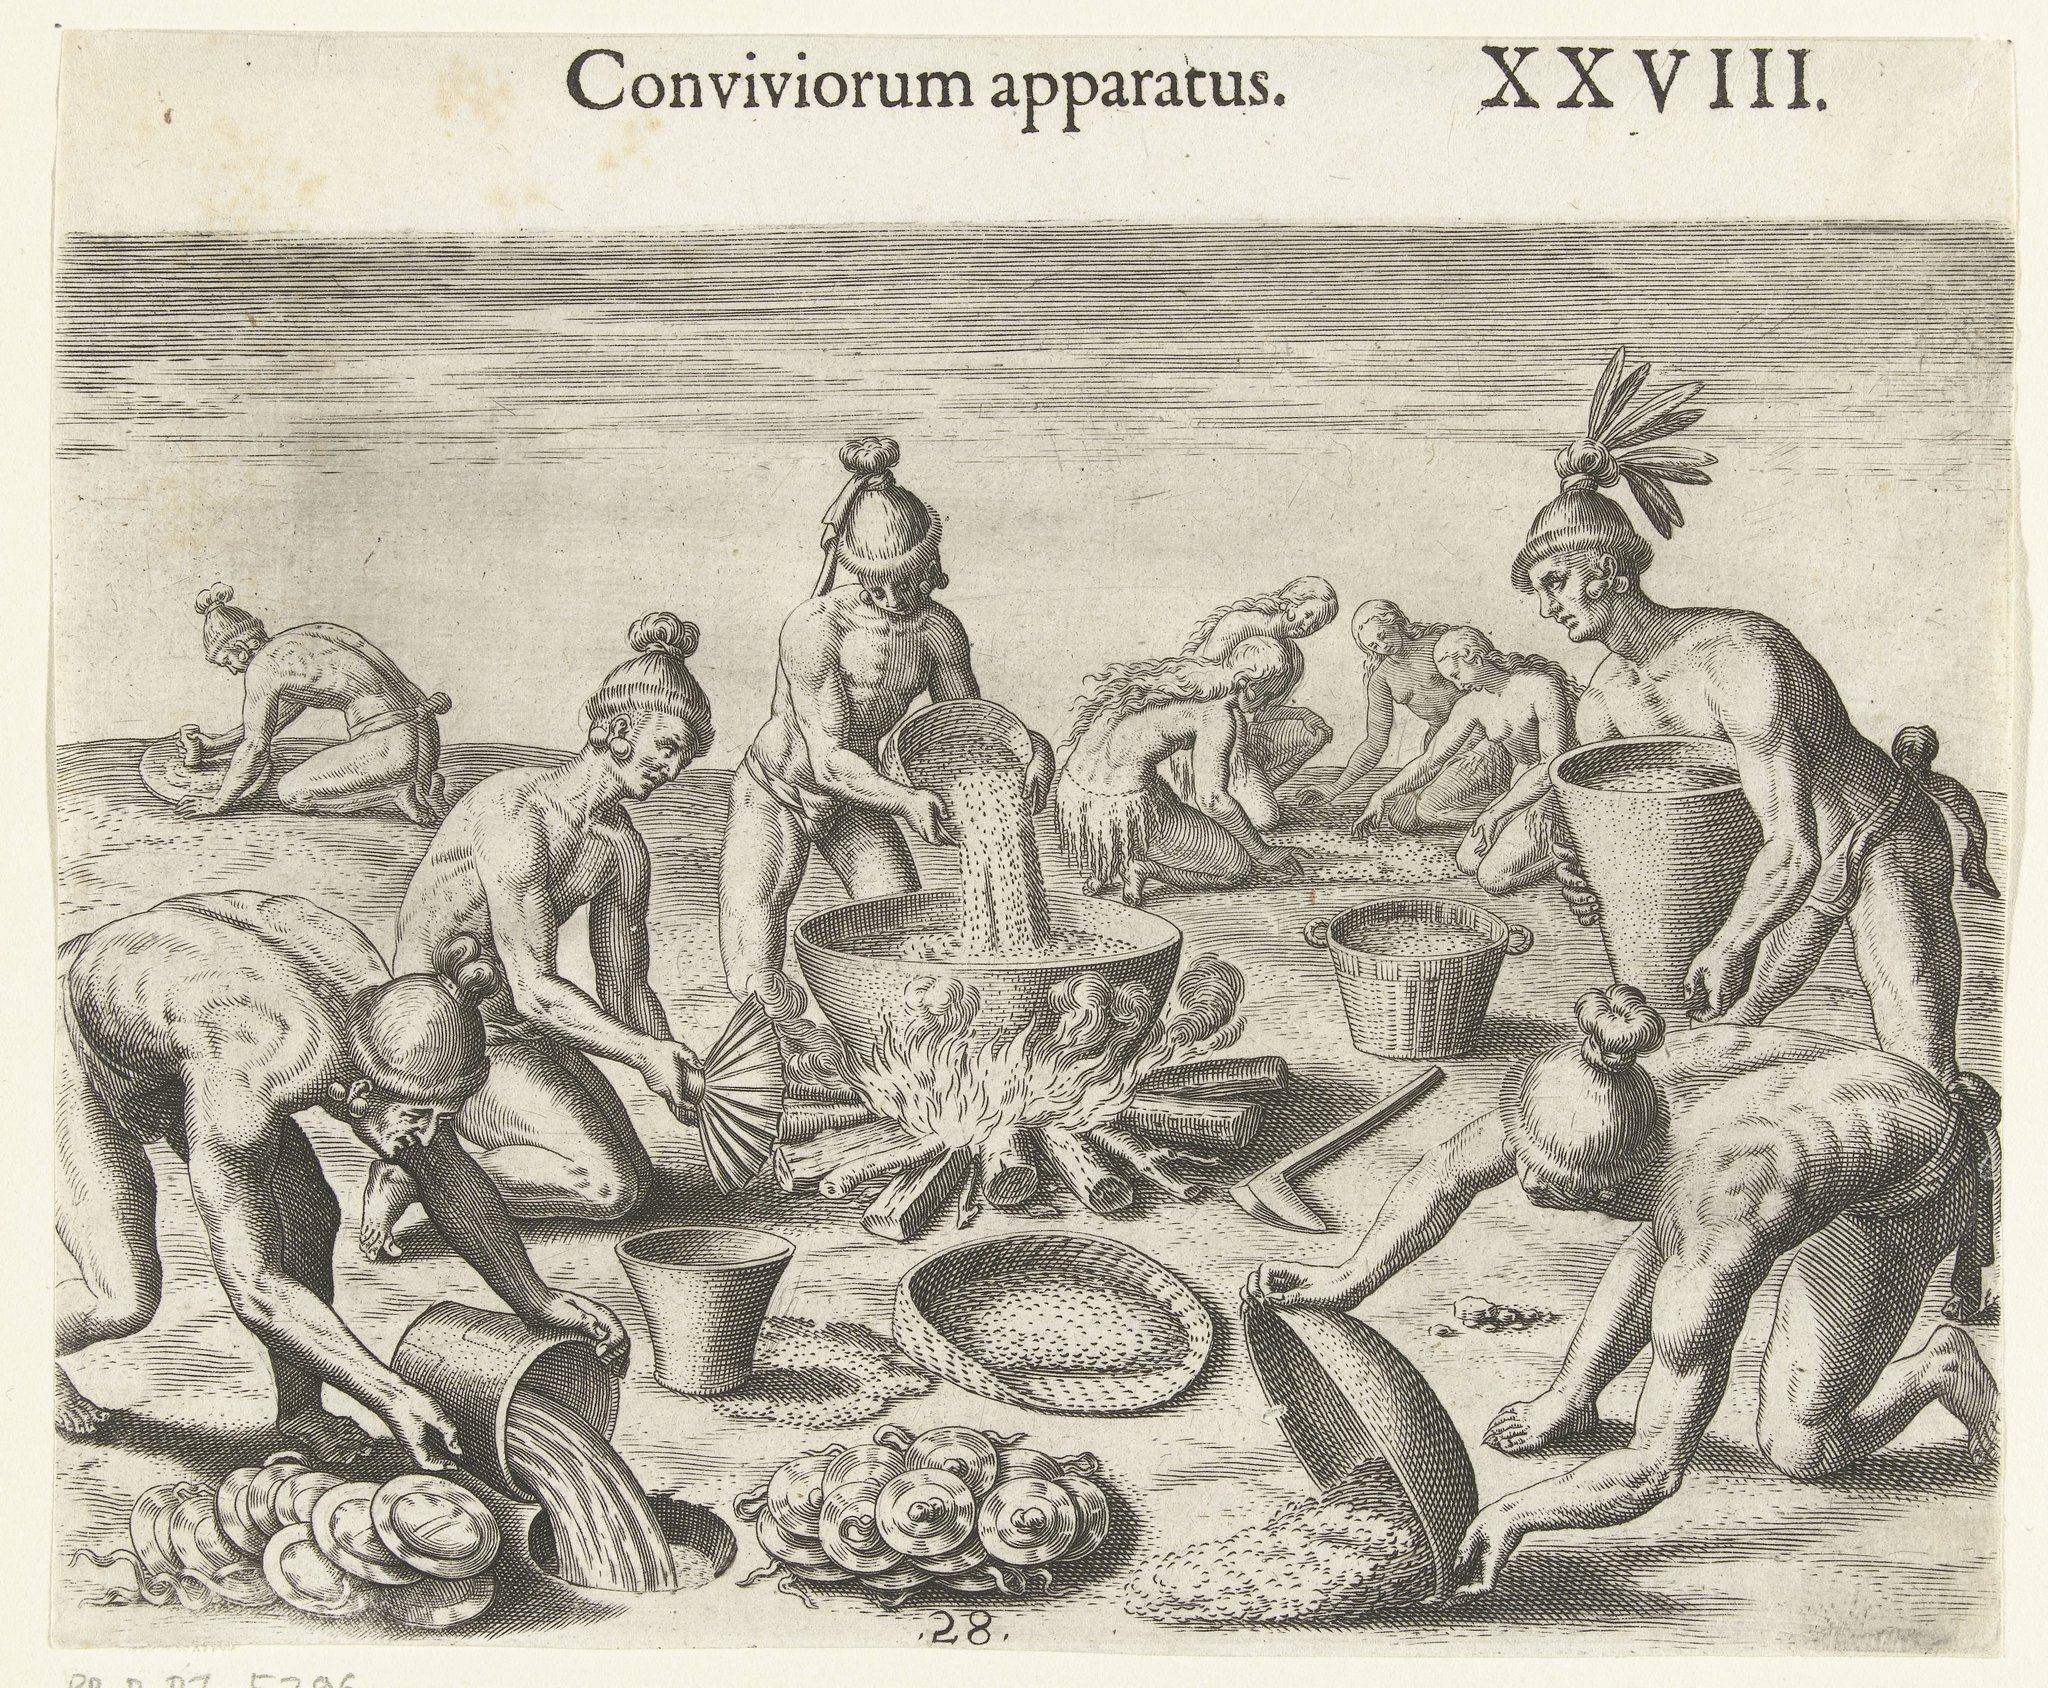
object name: book illustration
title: Voedselbereiding bij oorspronkelijke Amerikanen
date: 1591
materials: paper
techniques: engraving, letterpress printing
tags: preparation of food - cc - in the open air, cooking food - cc - in the open air, cereal, grain, corn (grass with grains, grown for food, e.g.: wheat, rice, rye, oats, maize, buckwheat, millet), native peoples of the americas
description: Afkomstig uit: Collectiones peregrinationum in Indiam occidentalem, dl. 2: René de Laudonnière, Brevis narratio eorum quae in Florida Americae provincia Gallis acciderunt. Frankfurt am Main: J. Wechelus, 1591.